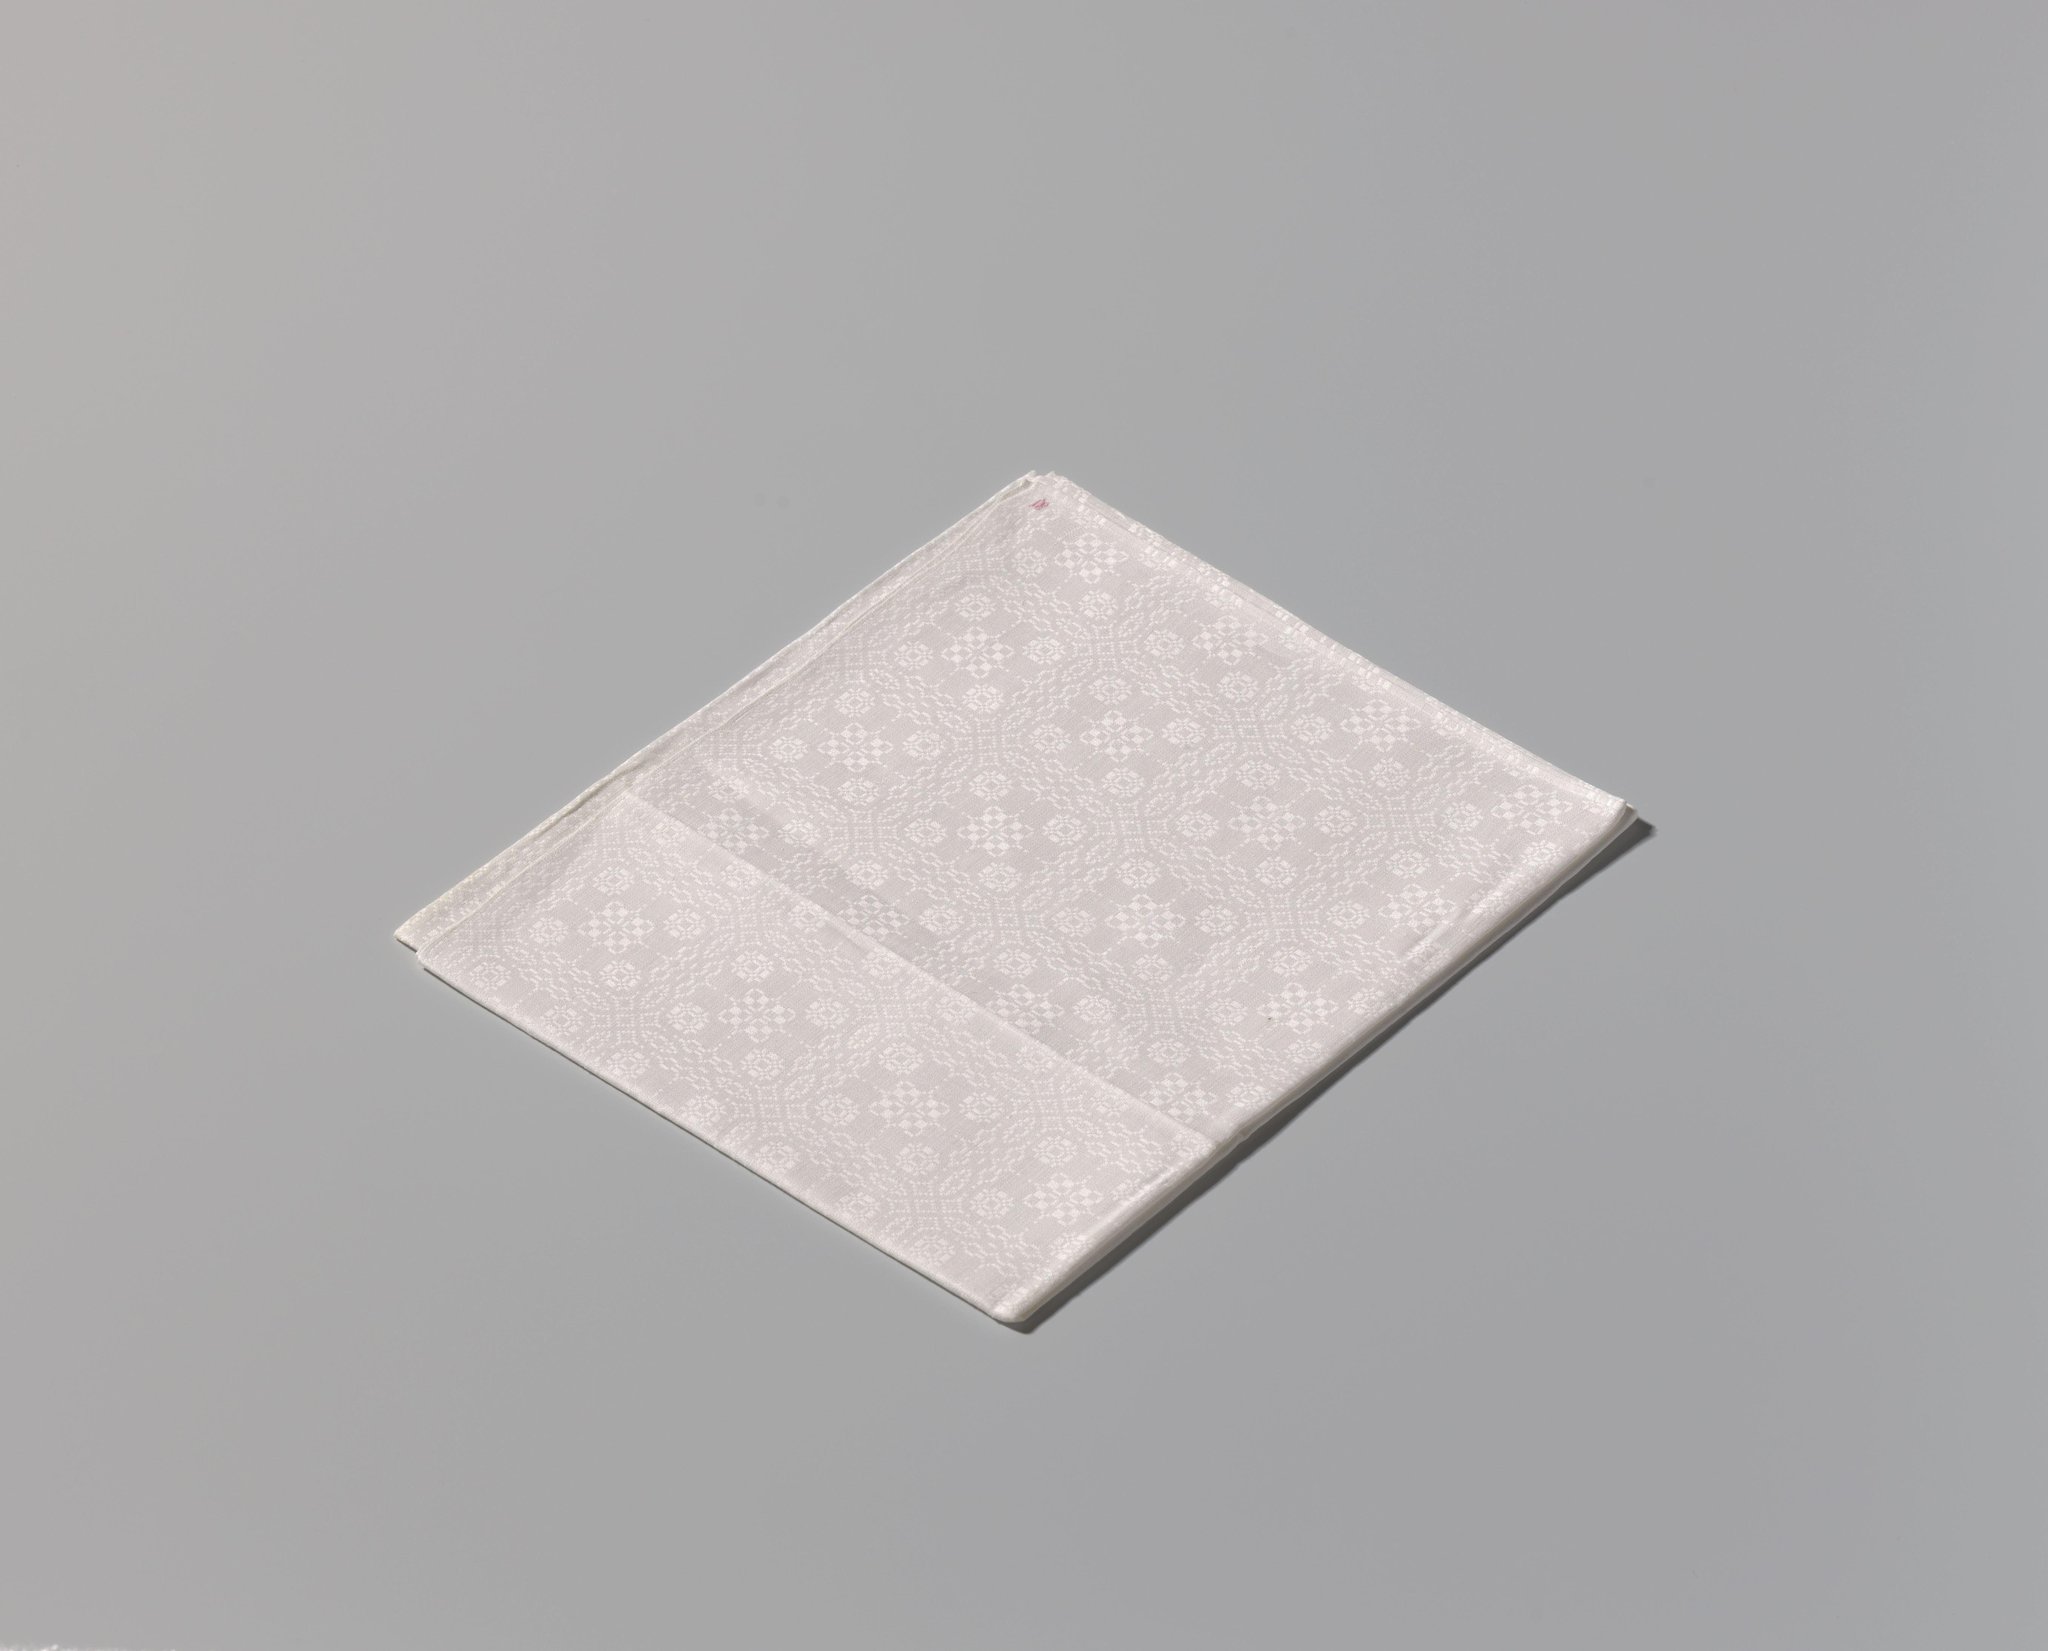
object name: napkin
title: Servet van pellendamast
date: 1675-1725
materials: linen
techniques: weave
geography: north brabant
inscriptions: mark: ‘18’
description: Servet van pellendamast. Elkaar snijdende rijen van ruiten vormen vierkanten, waarbinnen vijf blokken. Het servet is gehalveerd. Het servet hoort bij twaalf servetten en een tafellaken.